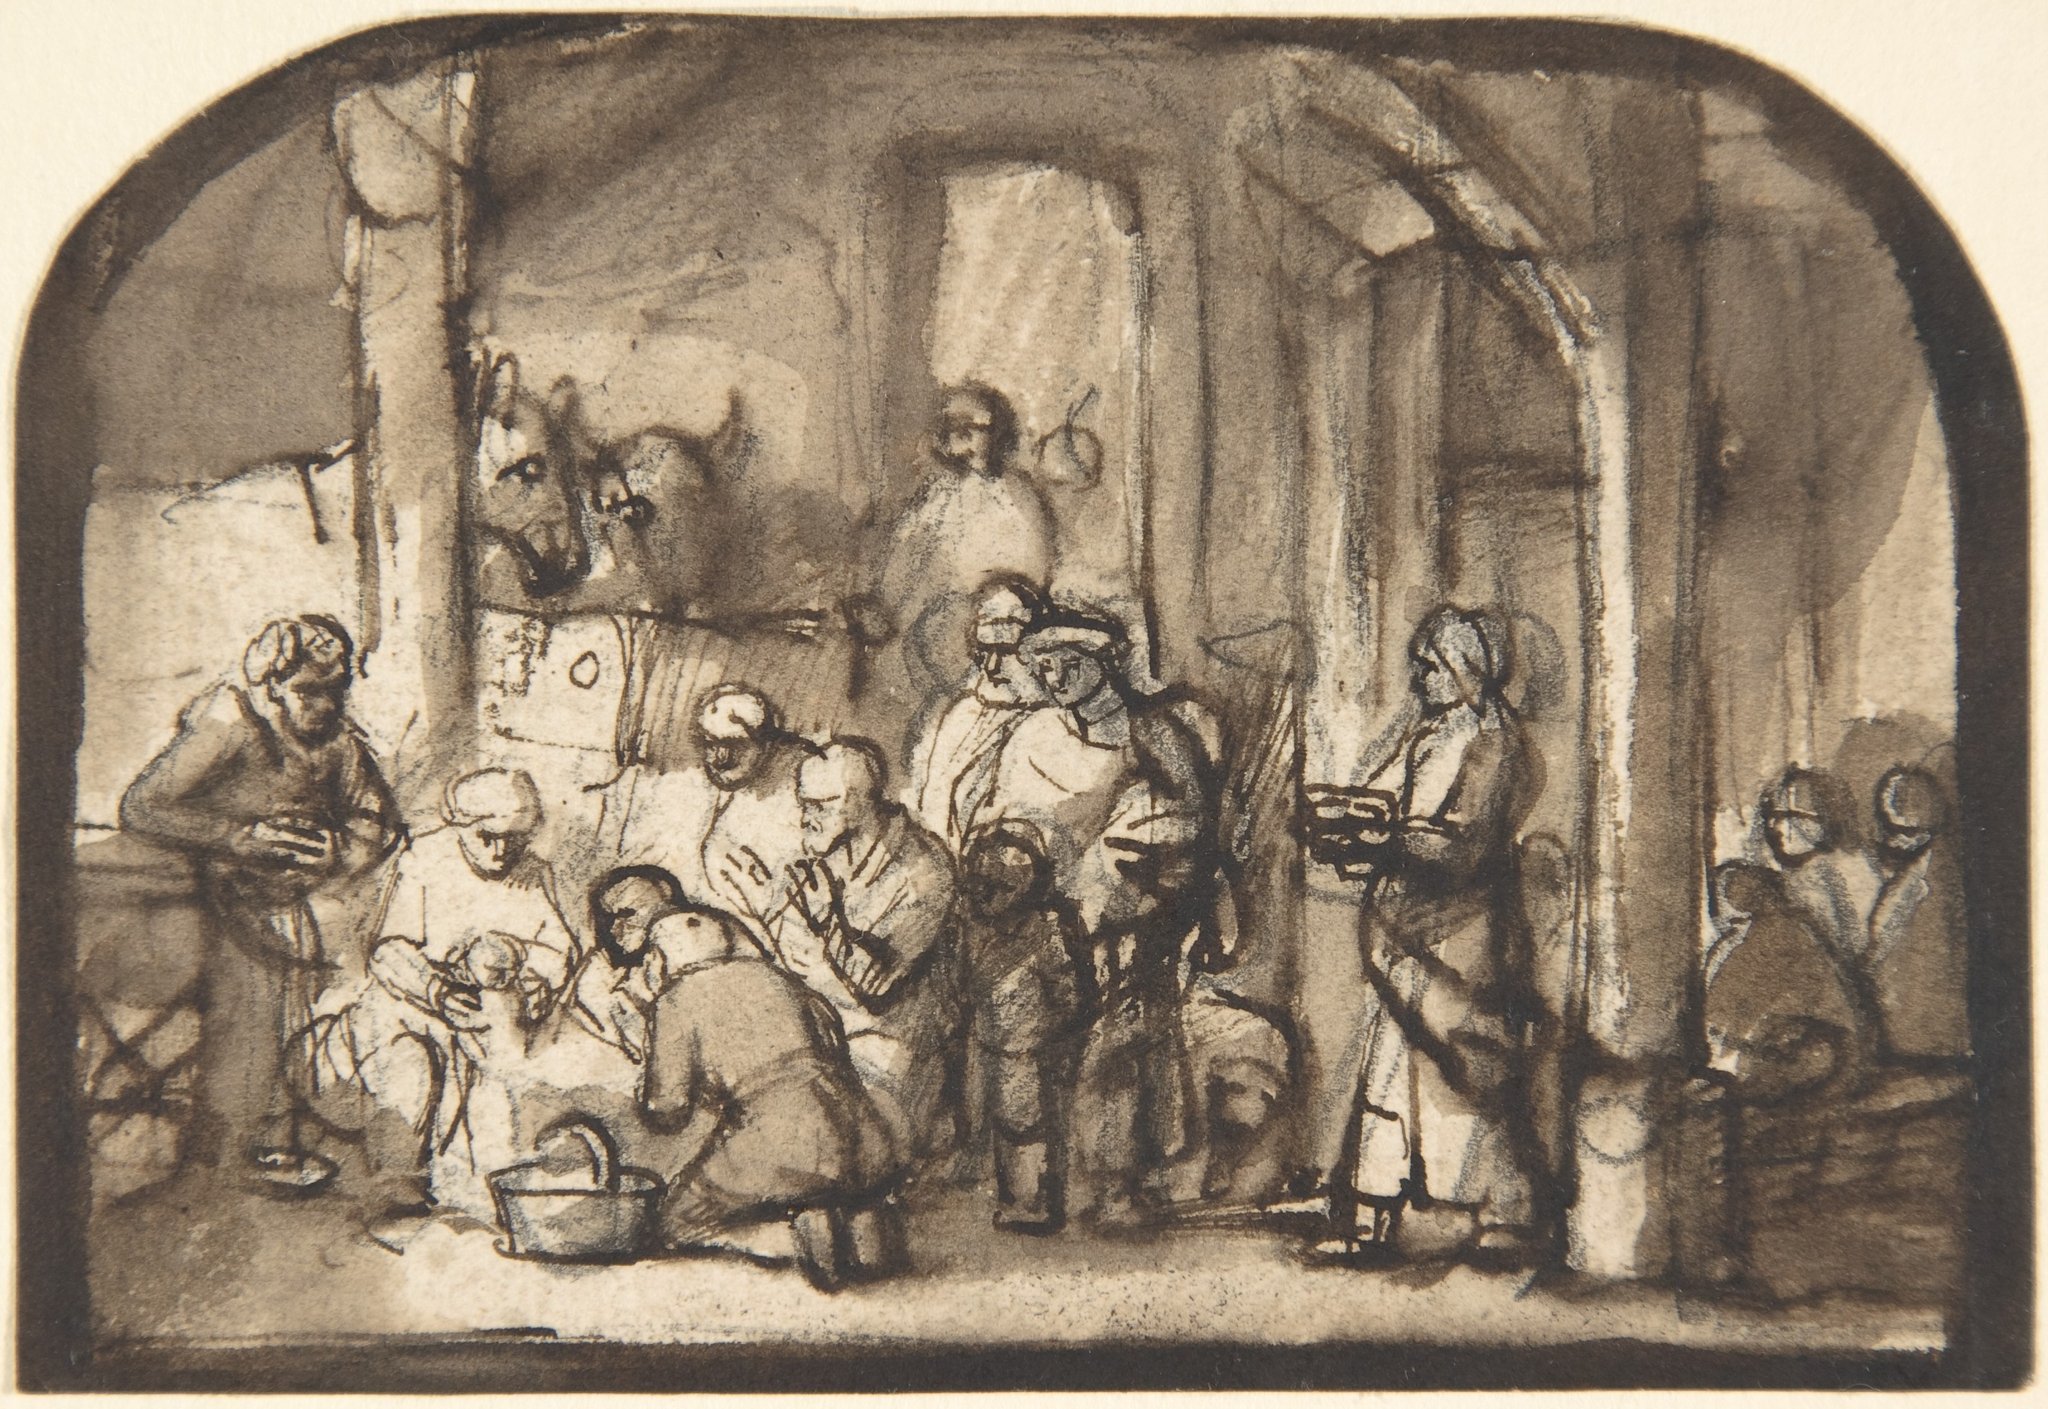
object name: drawing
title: The Adoration of the Shepherds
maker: samuel van hoogstraten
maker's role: artist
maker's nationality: dutch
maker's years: 1627-1678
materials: chalk, ink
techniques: brush, pen, wash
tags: animals,men,women,adoration of the shepherds